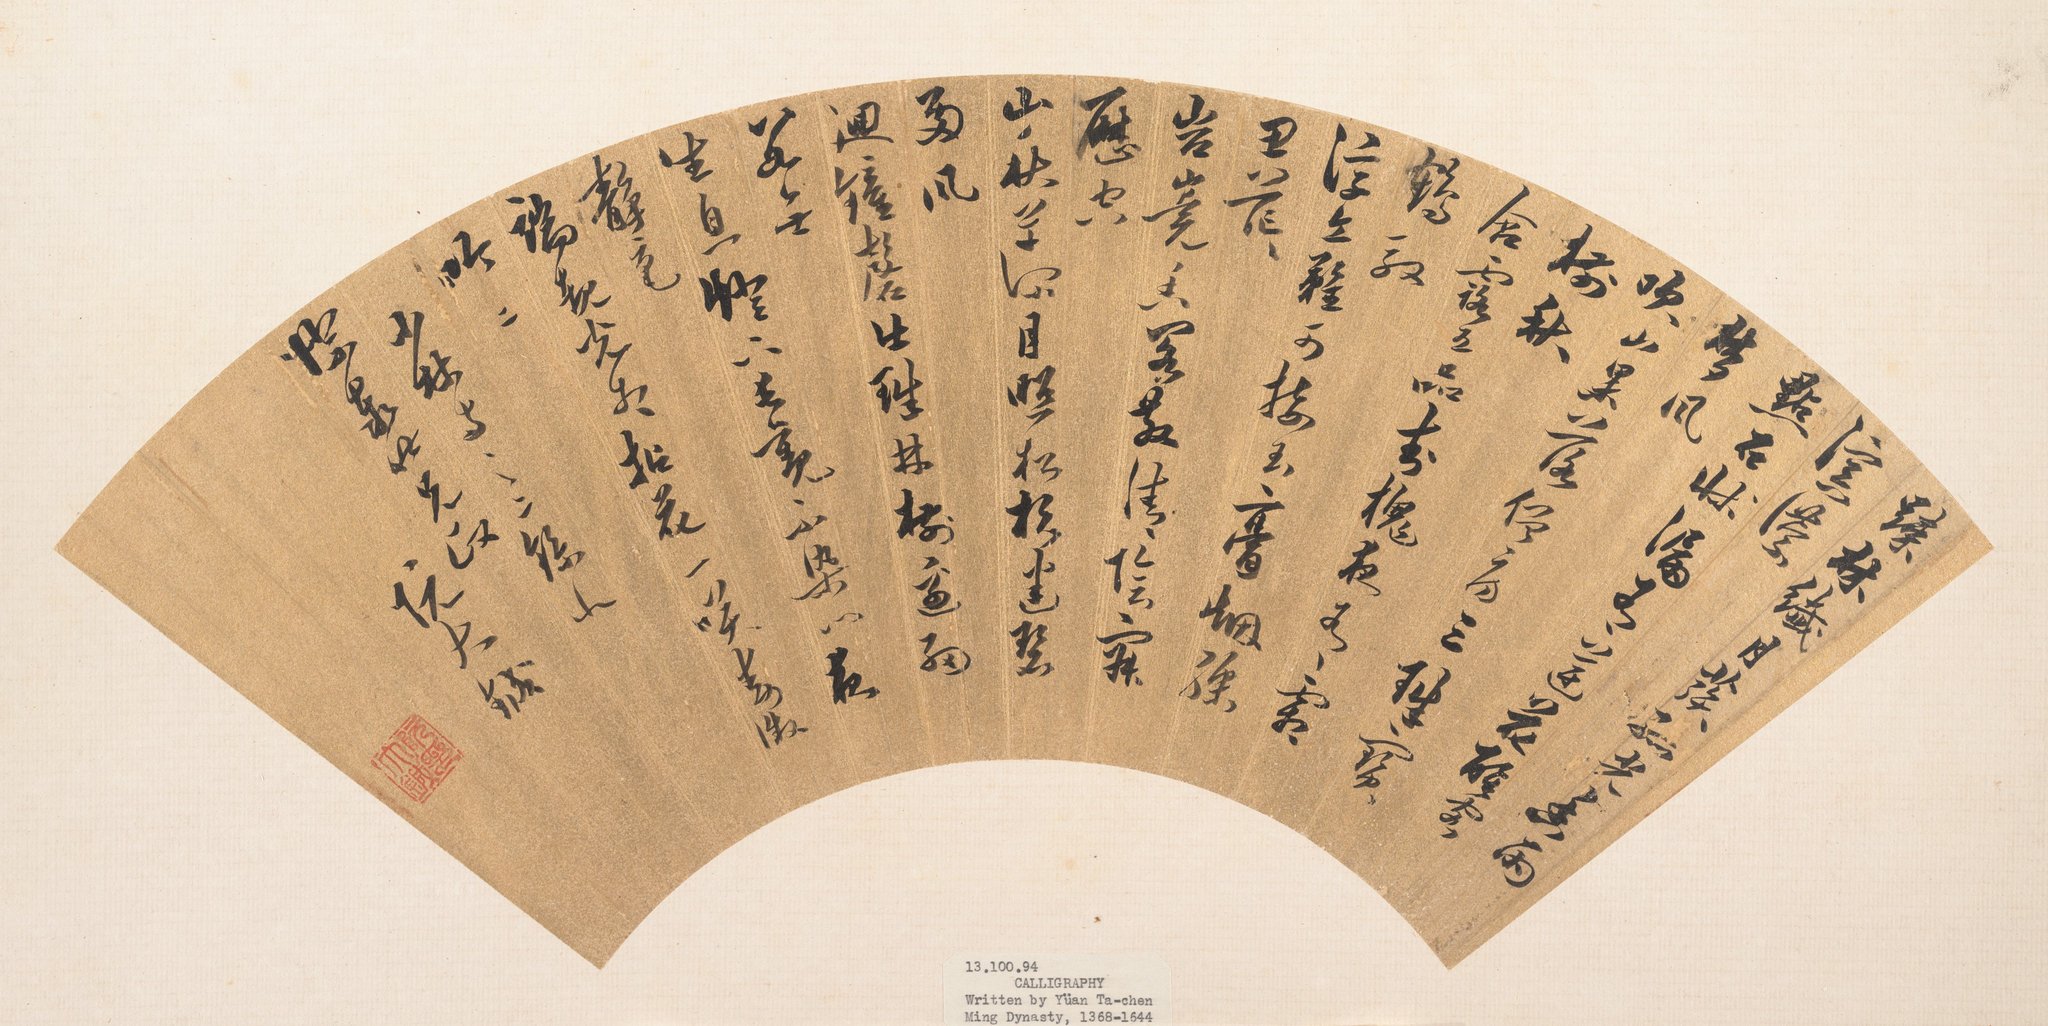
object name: folding fan mounted a an album leaf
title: Calligraphy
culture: chinese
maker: rüan dacheng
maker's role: calligrapher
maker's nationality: chinese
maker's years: 1550-1700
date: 1600-1633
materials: gold, ink, paper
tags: calligraphy